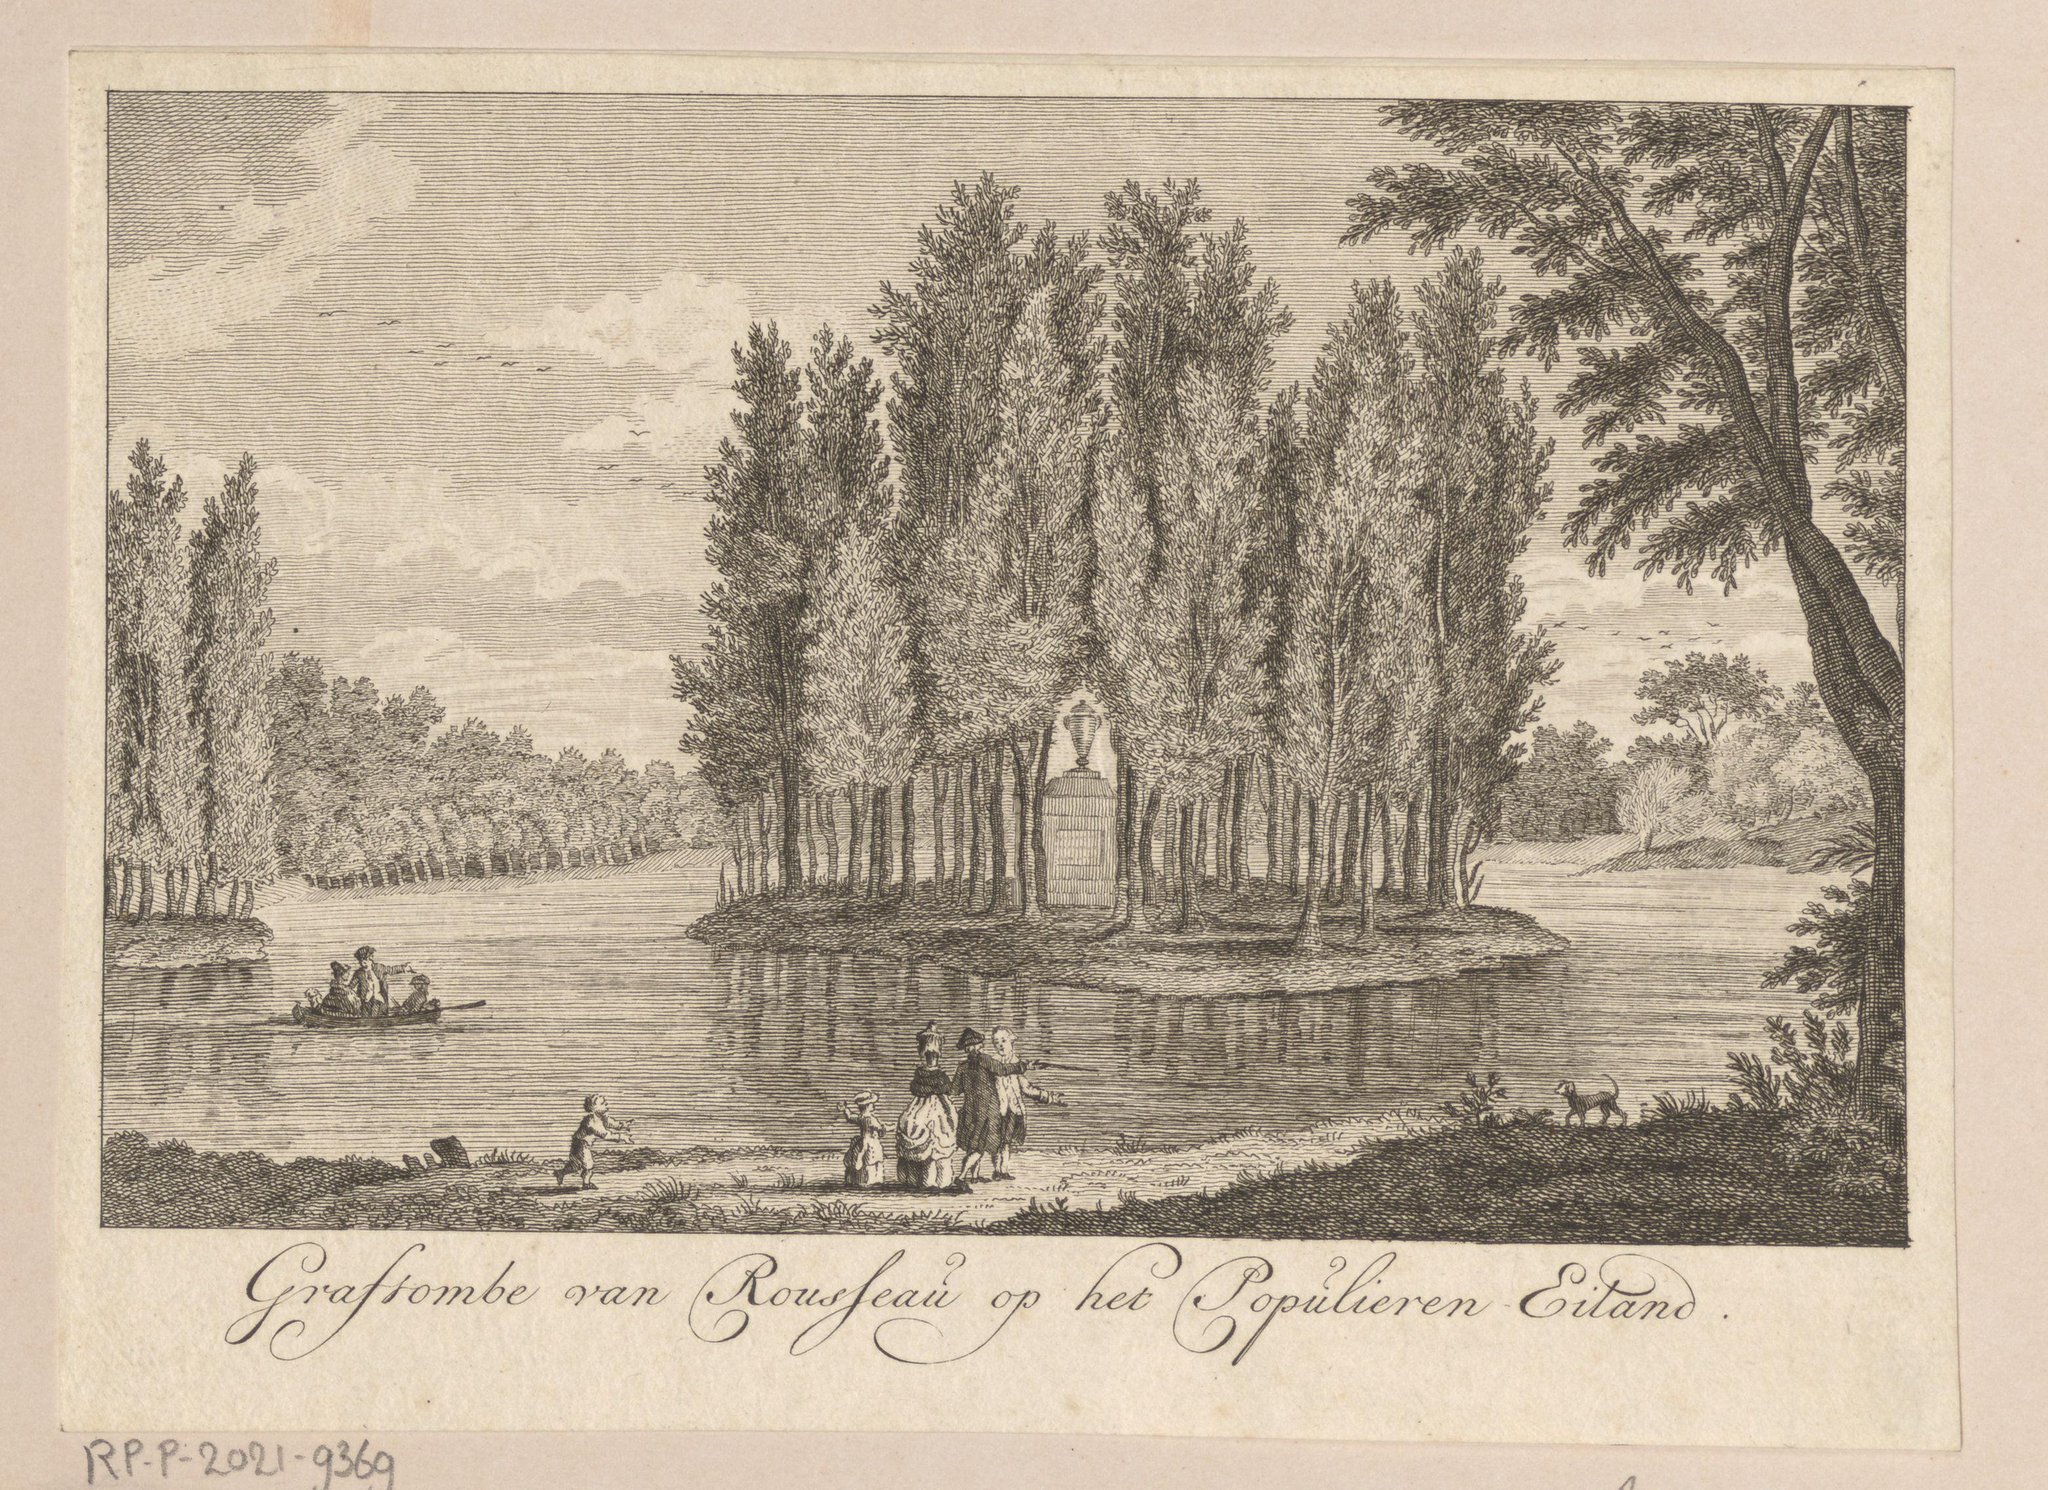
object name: print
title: Graftombe van Jean-Jacques Rousseau op het Ile des Peupliers te Ermenonville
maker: Anonymous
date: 1781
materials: paper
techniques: etching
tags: island, historical persons, grave, tomb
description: Prent mogelijk uit: Algemeene vaderlandsche letter-oefeningen (...). Amsterdam: A. van der Kroe, 1781.